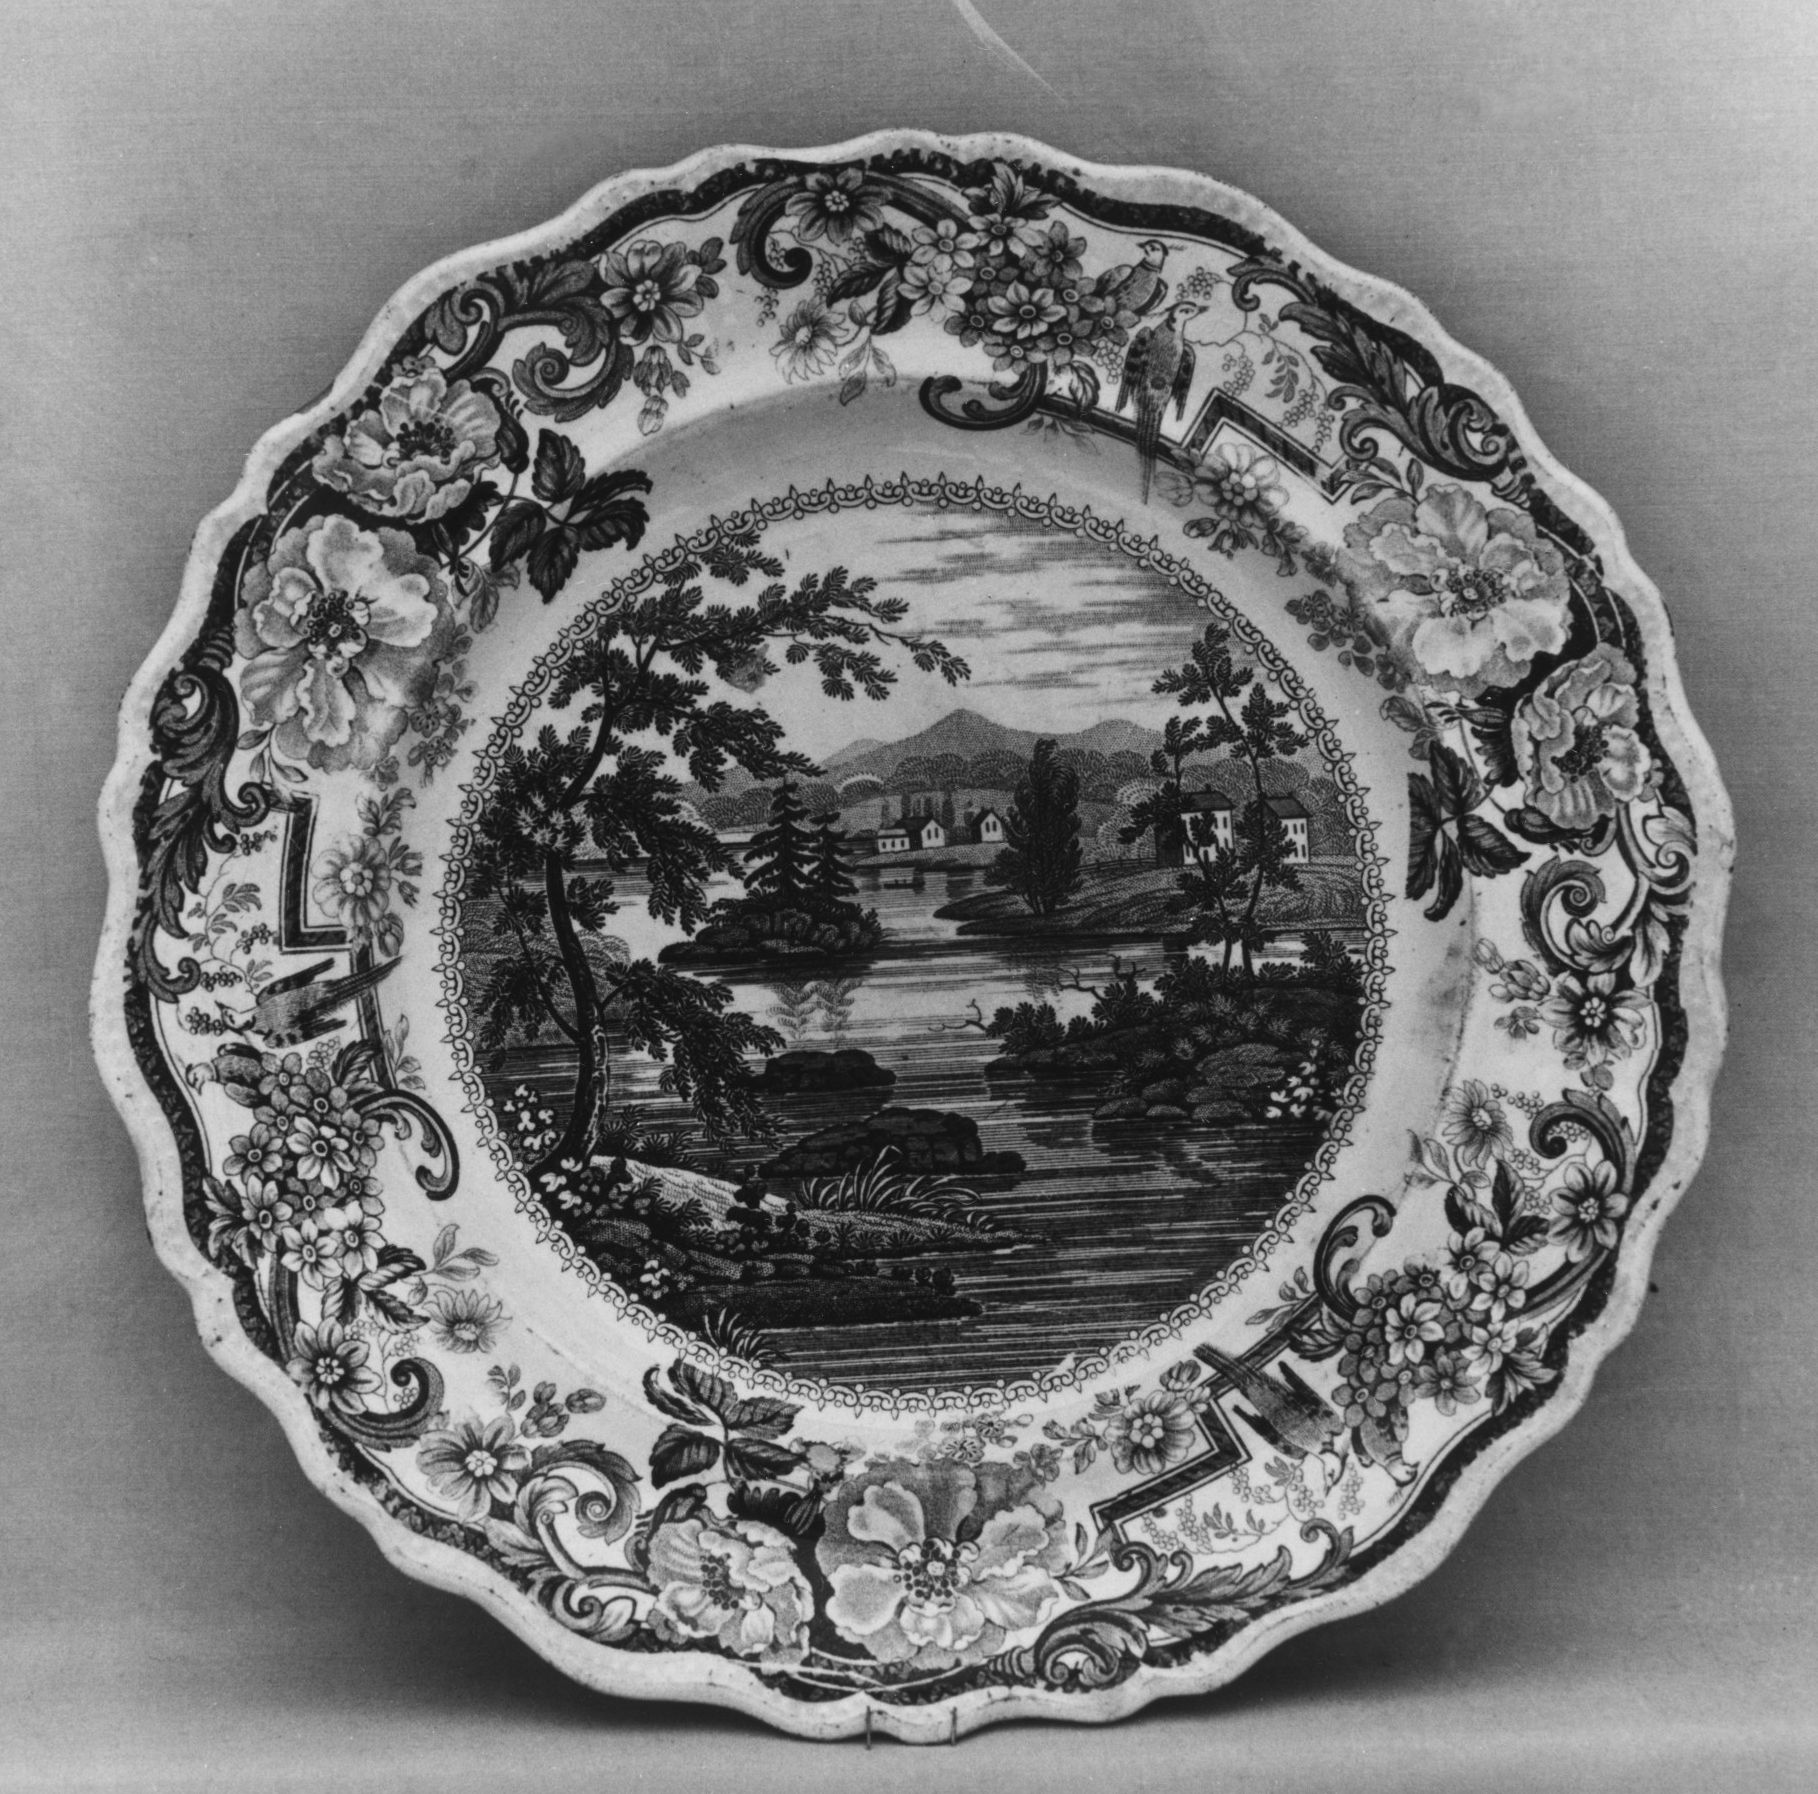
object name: plate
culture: british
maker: james and ralph clews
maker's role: maker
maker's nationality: british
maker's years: 1813-1836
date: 1822-1834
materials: earthenware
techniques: transfer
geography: england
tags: birds,landscapes